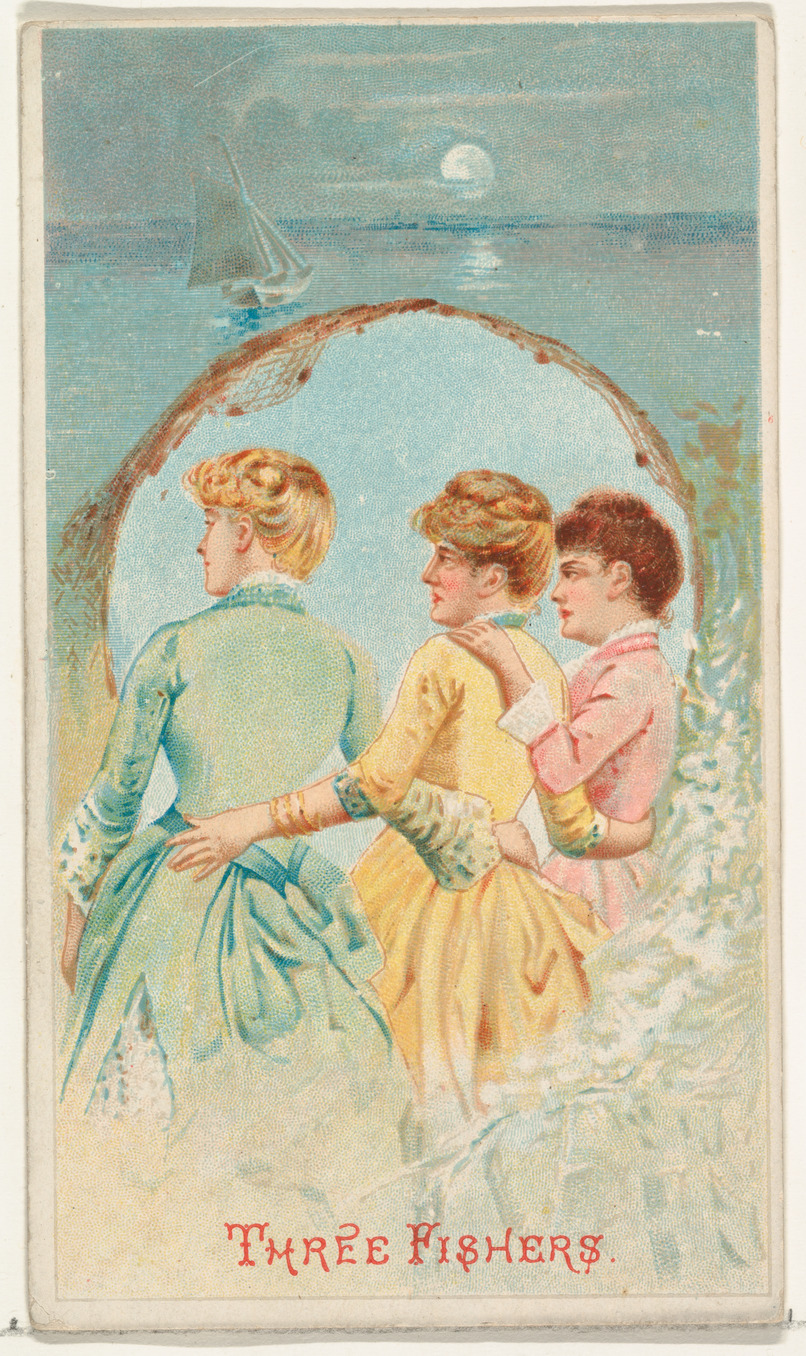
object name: print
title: Three Fishers, from the Illustrated Songs series (N116) issued by W. Duke, Sons & Co. to promote Honest Long Cut Tobacco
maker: w. duke, sons & co.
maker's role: publisher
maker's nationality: american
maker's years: 1870-1920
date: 1893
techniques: color lithograph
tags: profiles,women